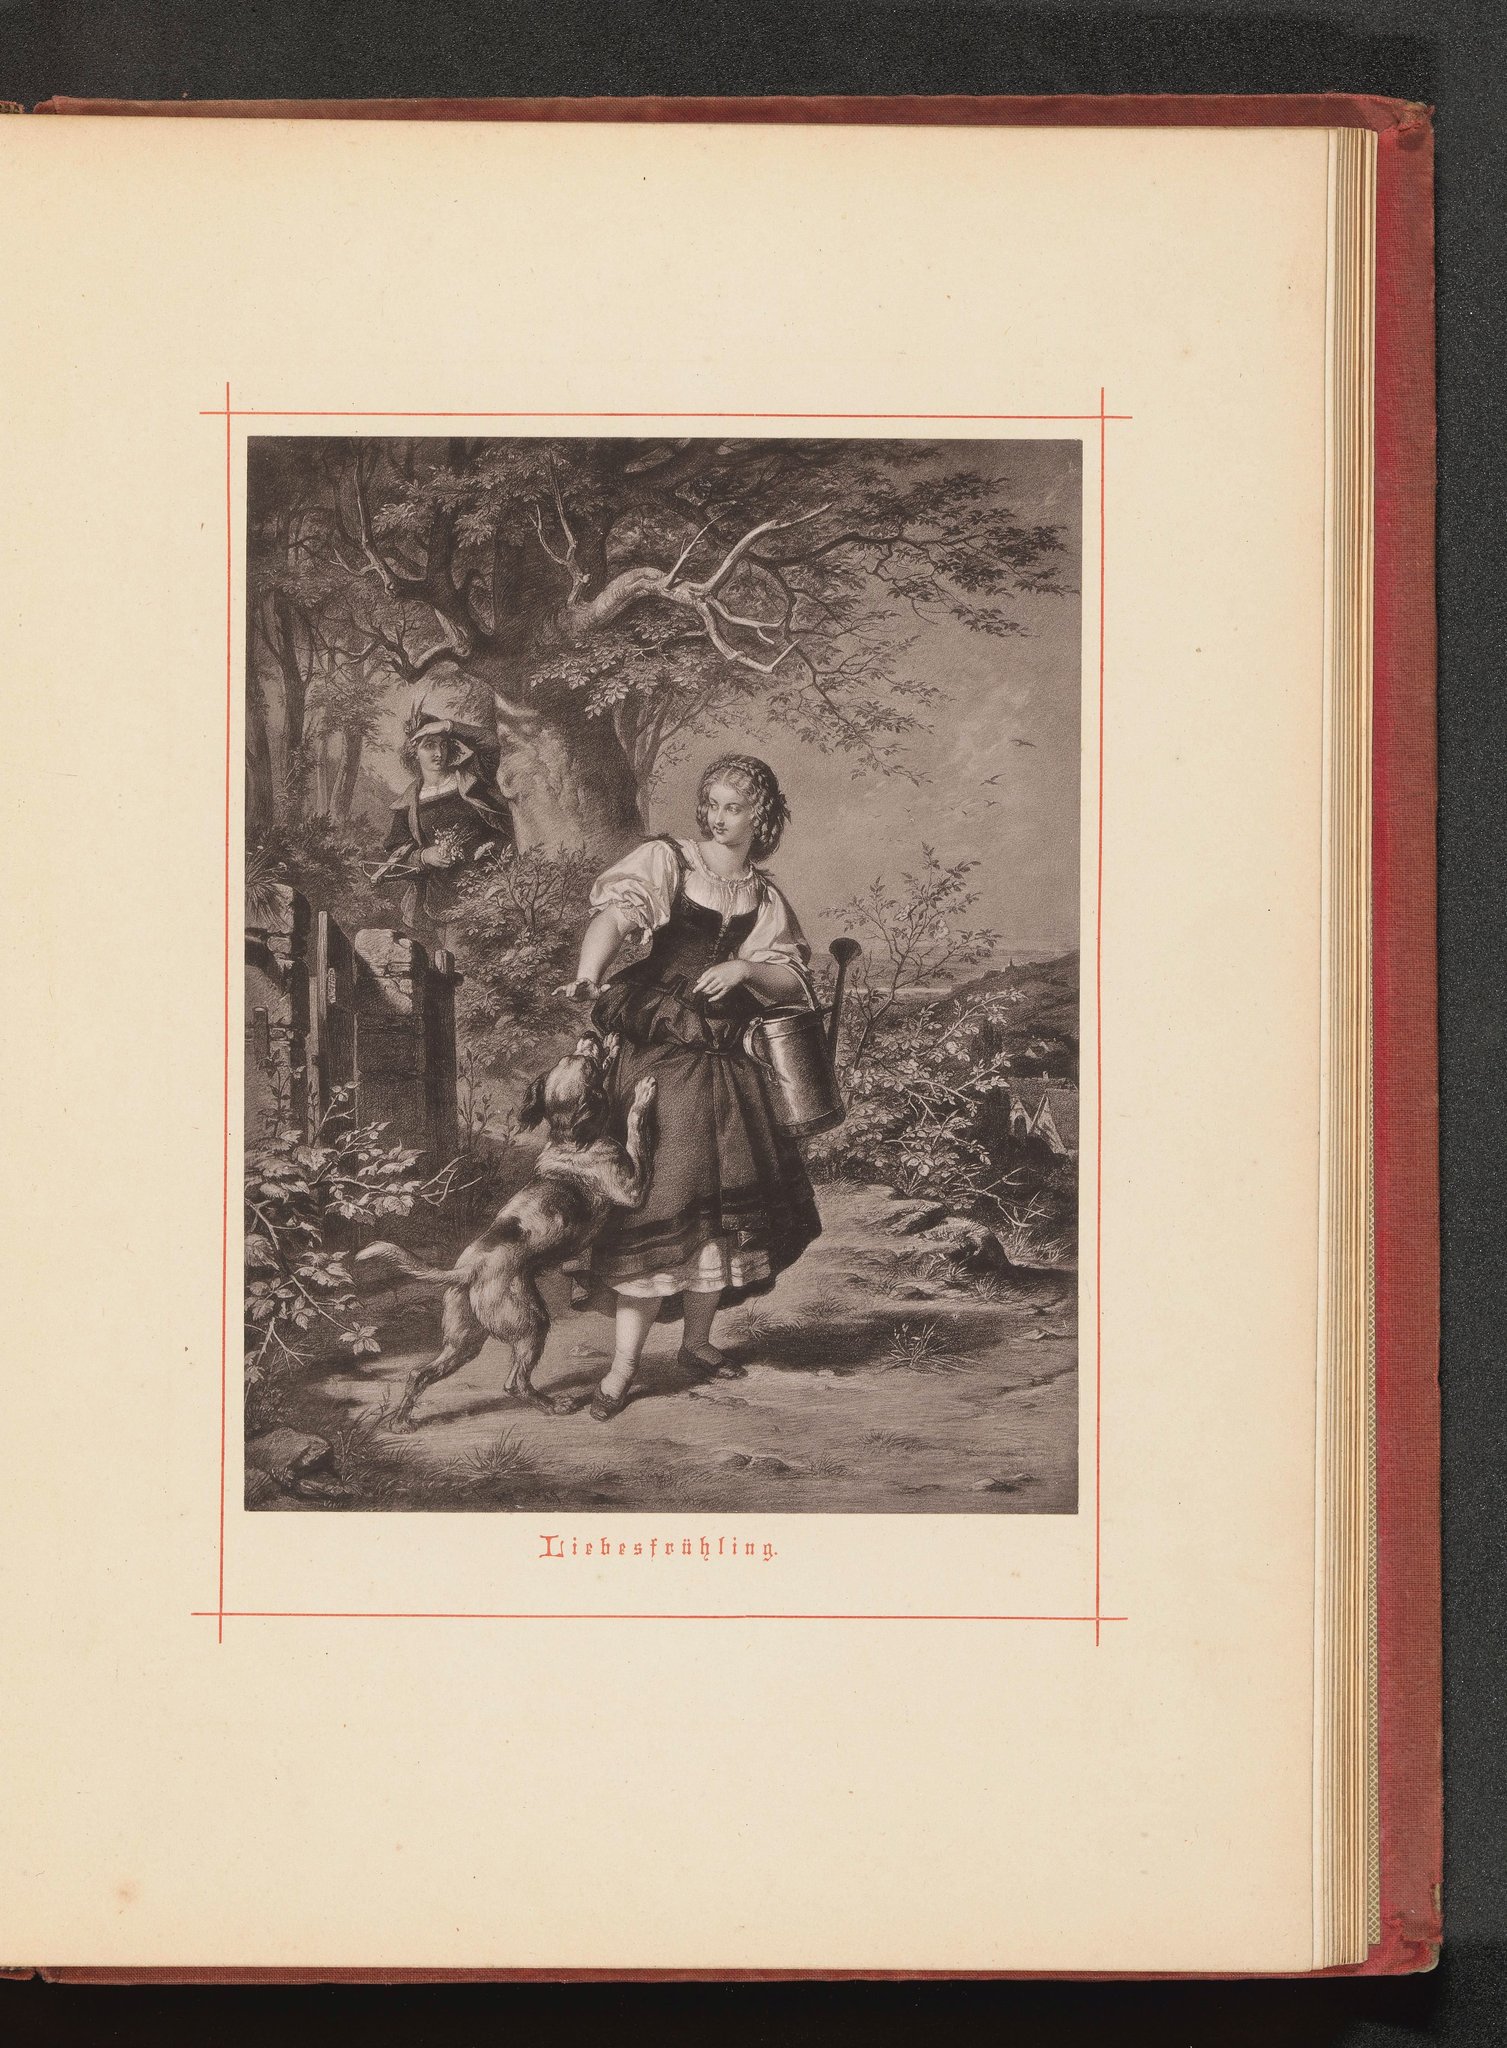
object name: reproduction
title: Fotoreproductie van een tekening van een meisje met een hond die vanuit de verte wordt bekeken door een jongen achter een boom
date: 1871-1881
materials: paper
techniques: photograph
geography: germany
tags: lovers' meeting